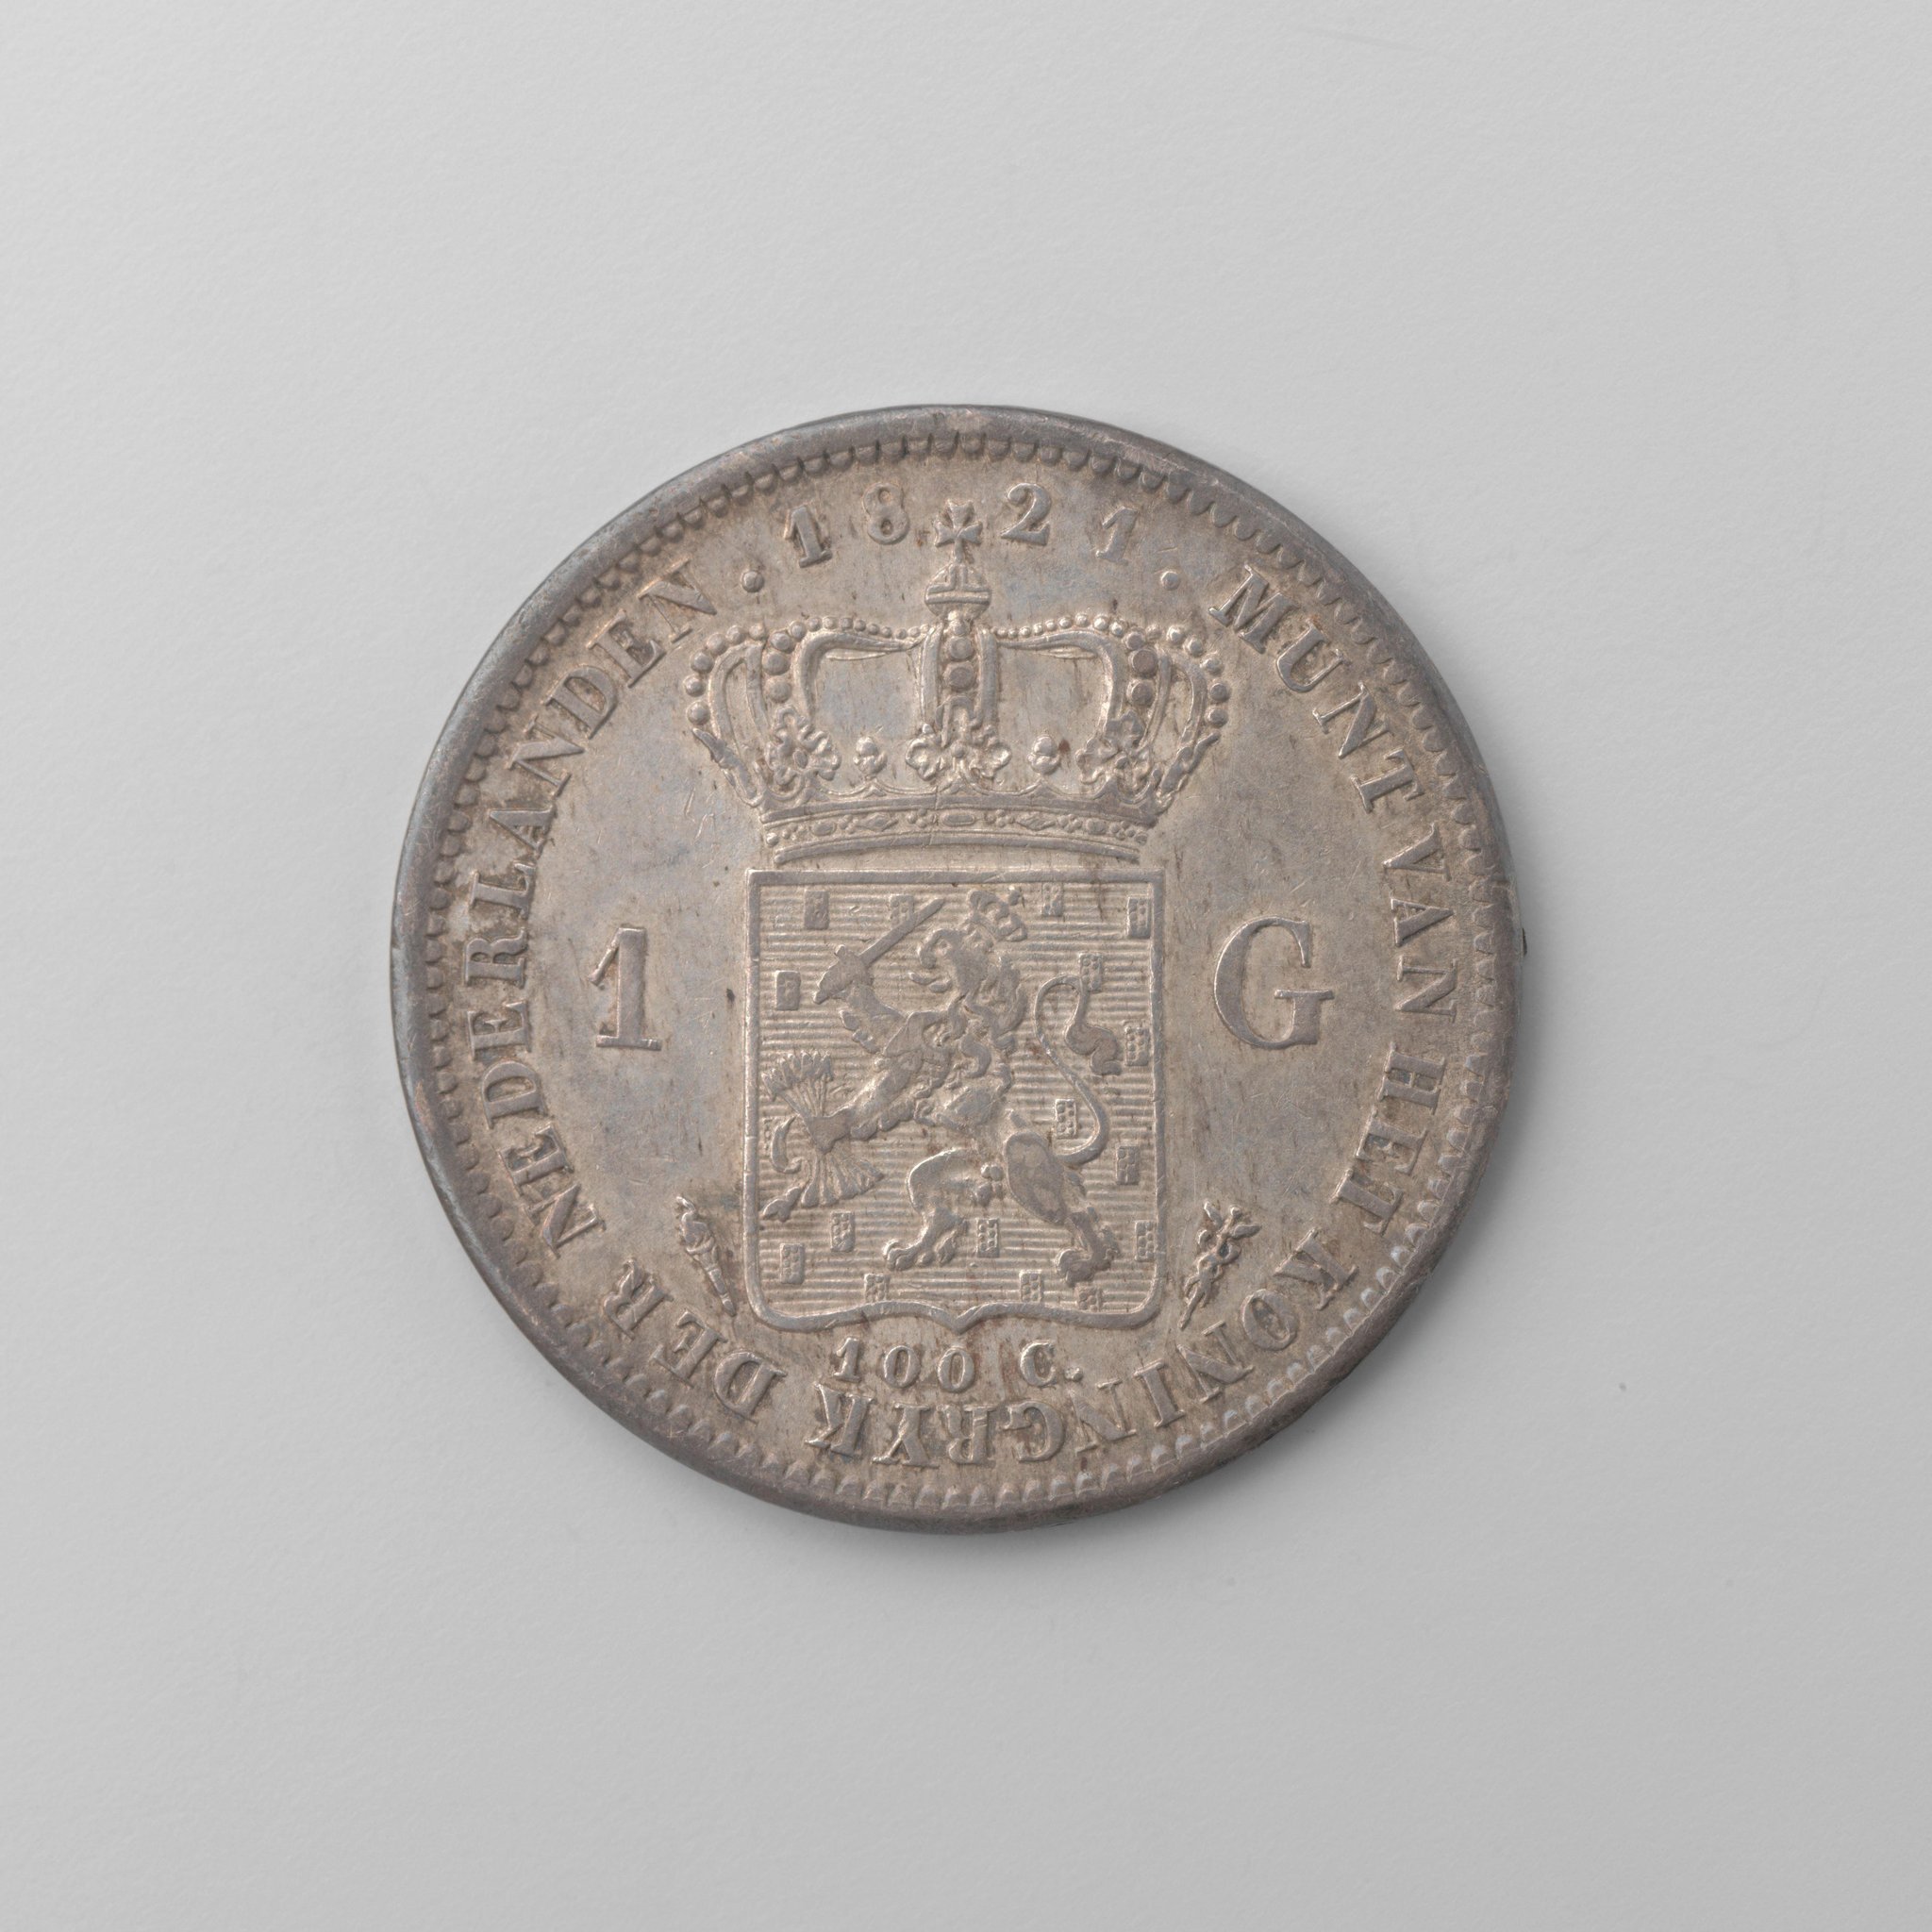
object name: coin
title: Nederlandse gulden, 1821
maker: william i of the netherlands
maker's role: koning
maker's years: 1772-1843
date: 1821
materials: silver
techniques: striking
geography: utrecht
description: Zilveren munt. Voorzijde: borstbeeld naar rechts. Keerzijde: tussen waarde-aanduiding 1 G gekroond rijkswapenschild. Jaartal boven kroon. Randschrift.